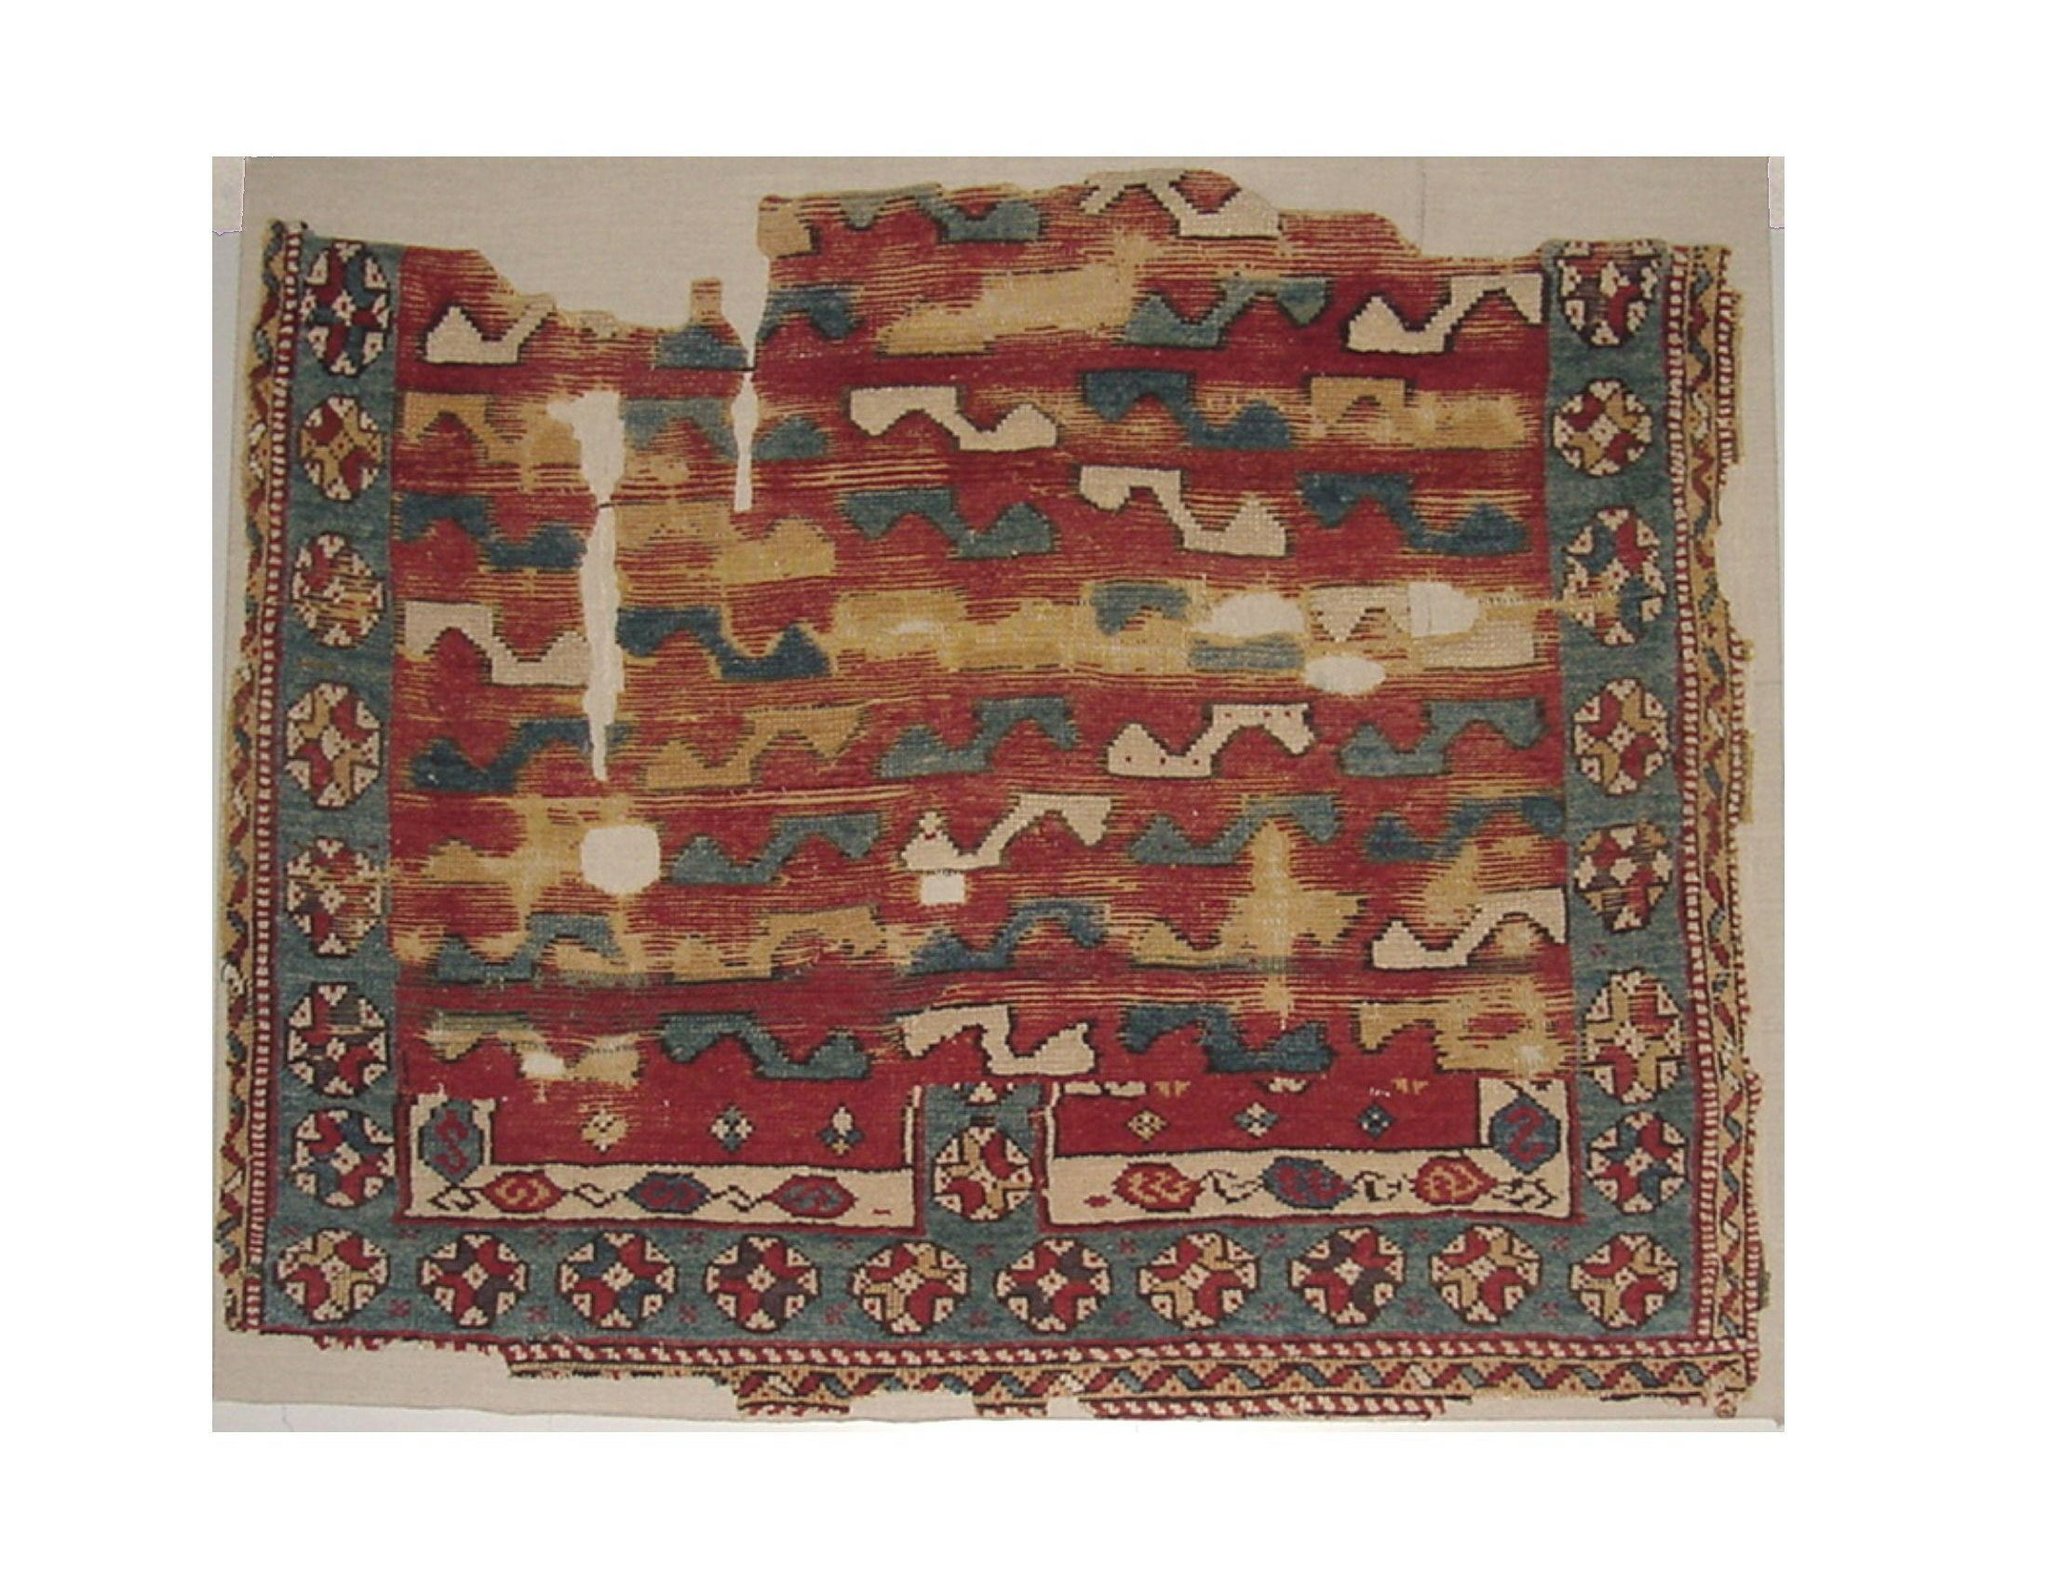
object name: carpet fragment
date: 1701-1800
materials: wool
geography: turkey